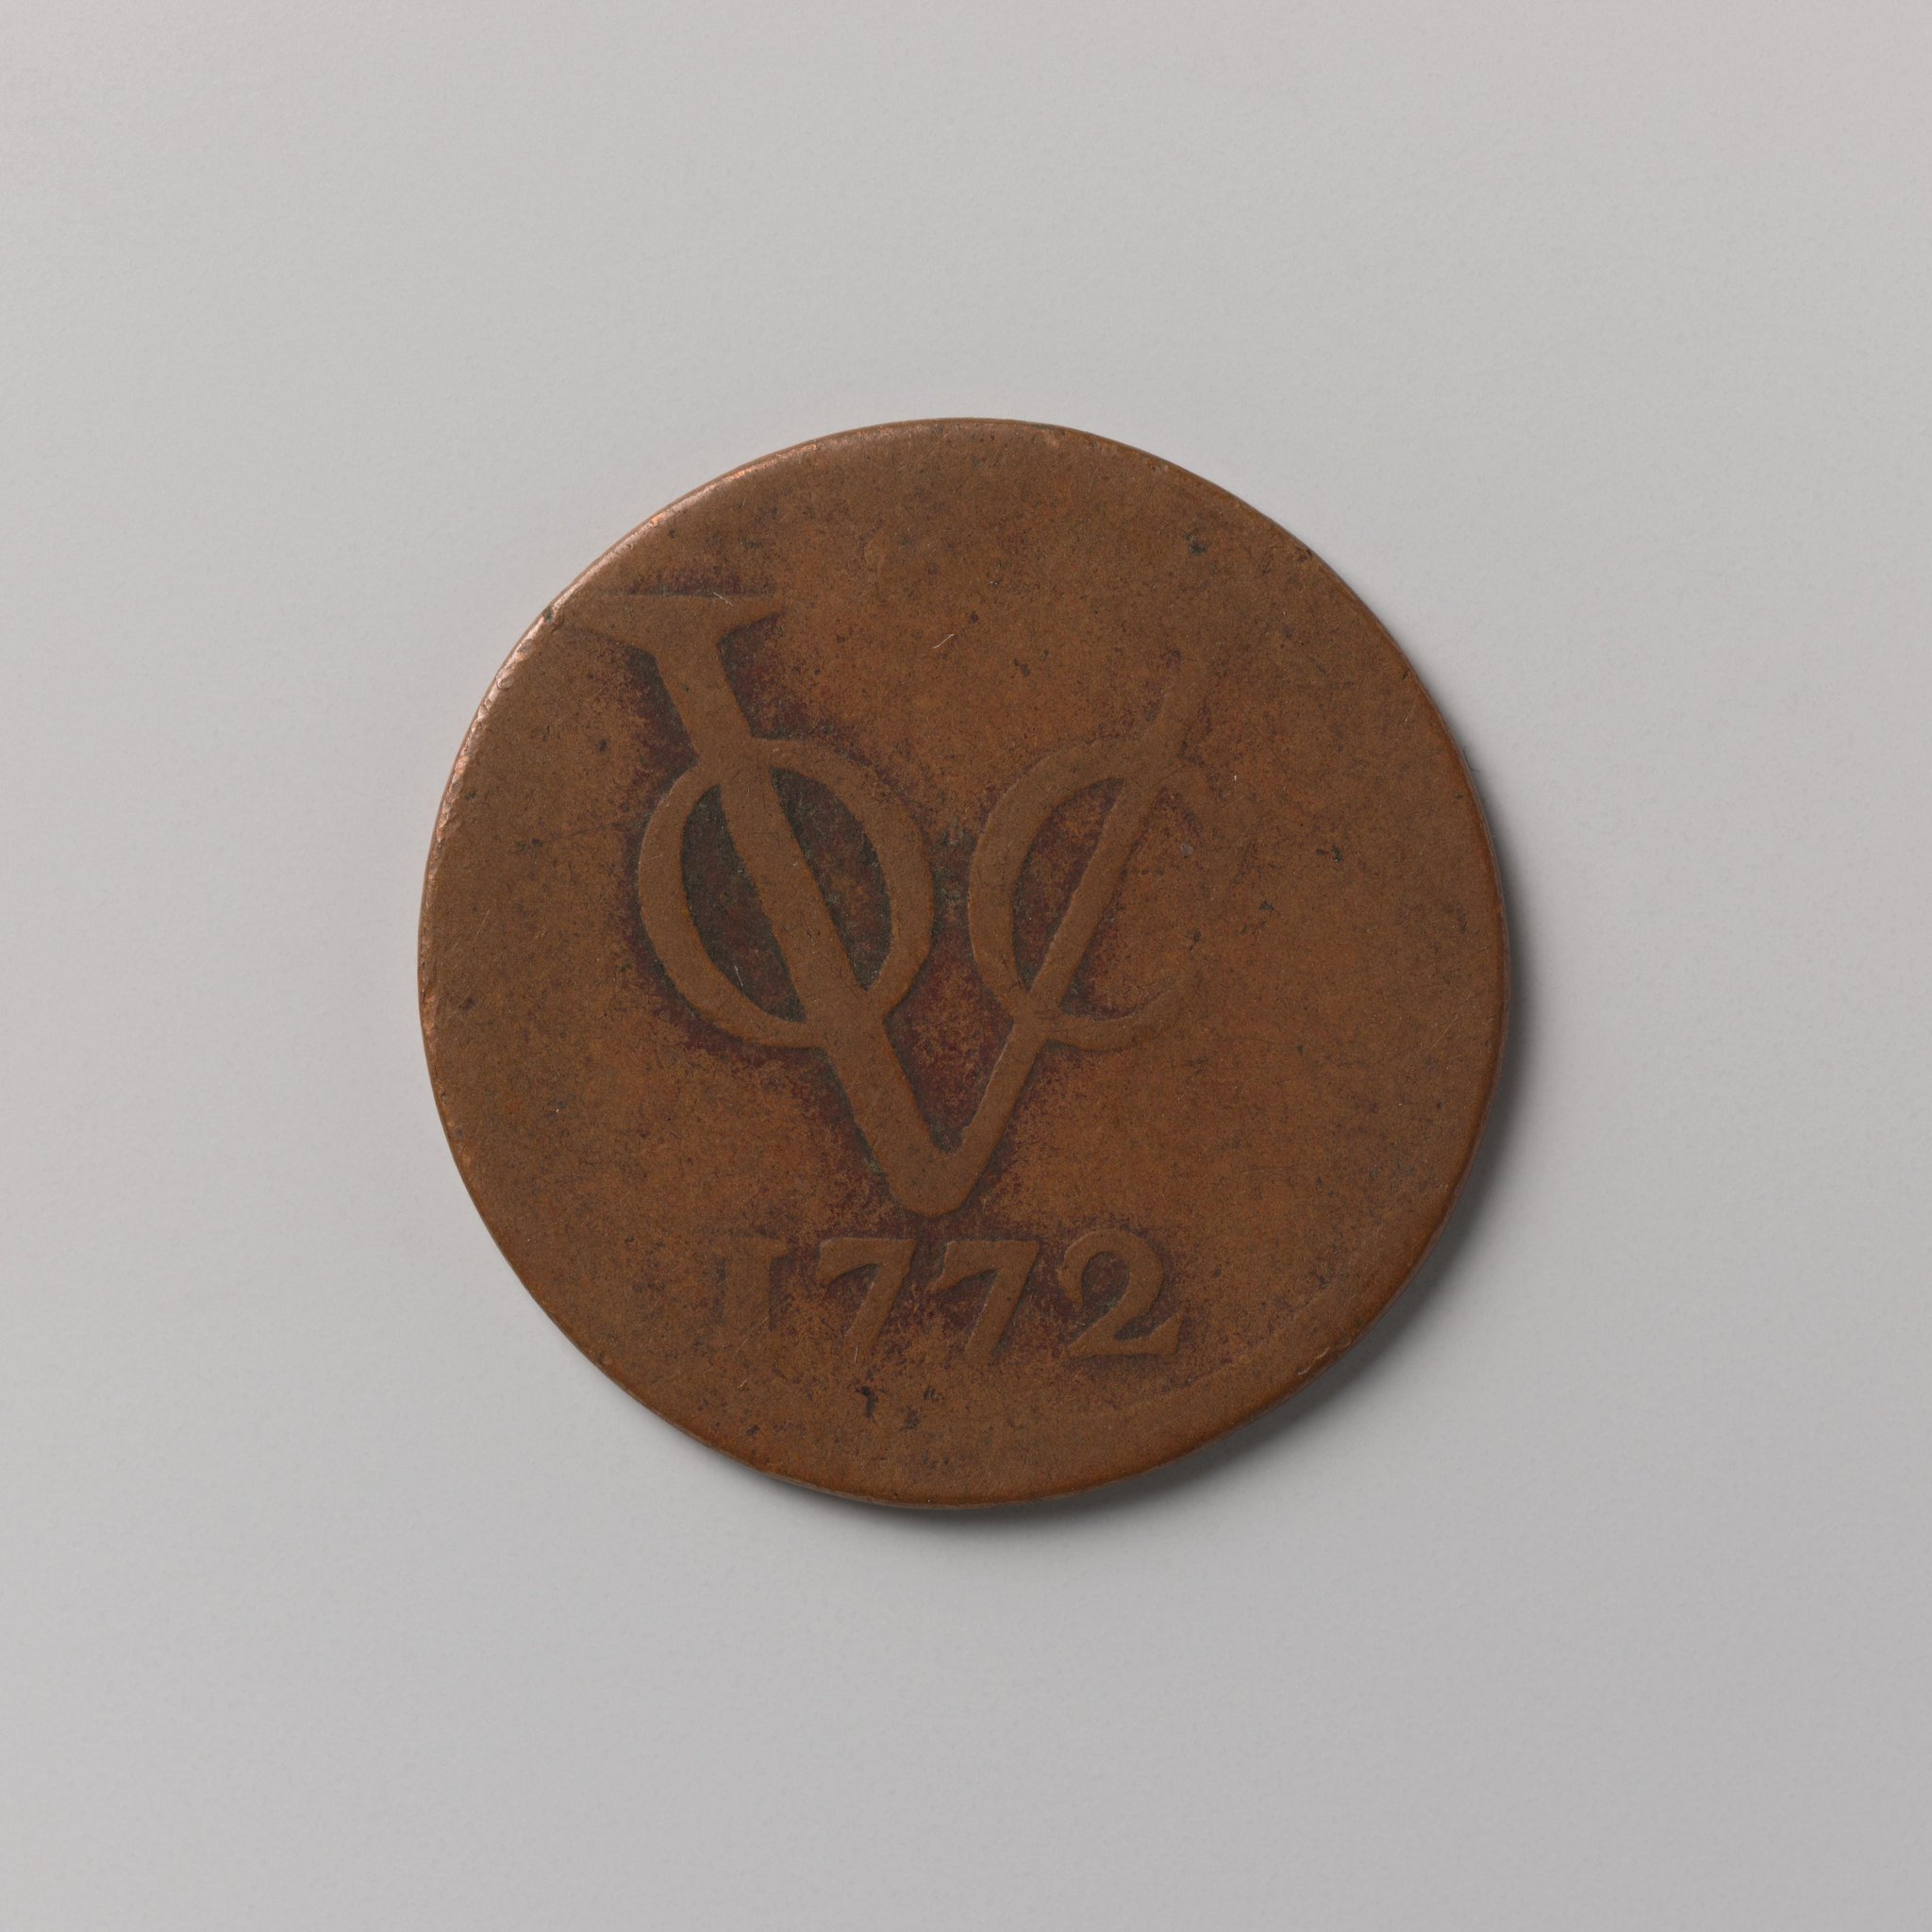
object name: coin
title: VOC, duit Holland, 1772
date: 1772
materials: copper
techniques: striking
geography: dordrecht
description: Koperen munt. Voorzijde: gekroond wapenschild van Holland. Keerzijde: monogram van de VOC, waarboven muntteken en waaronder jaartal. Gladde rand.